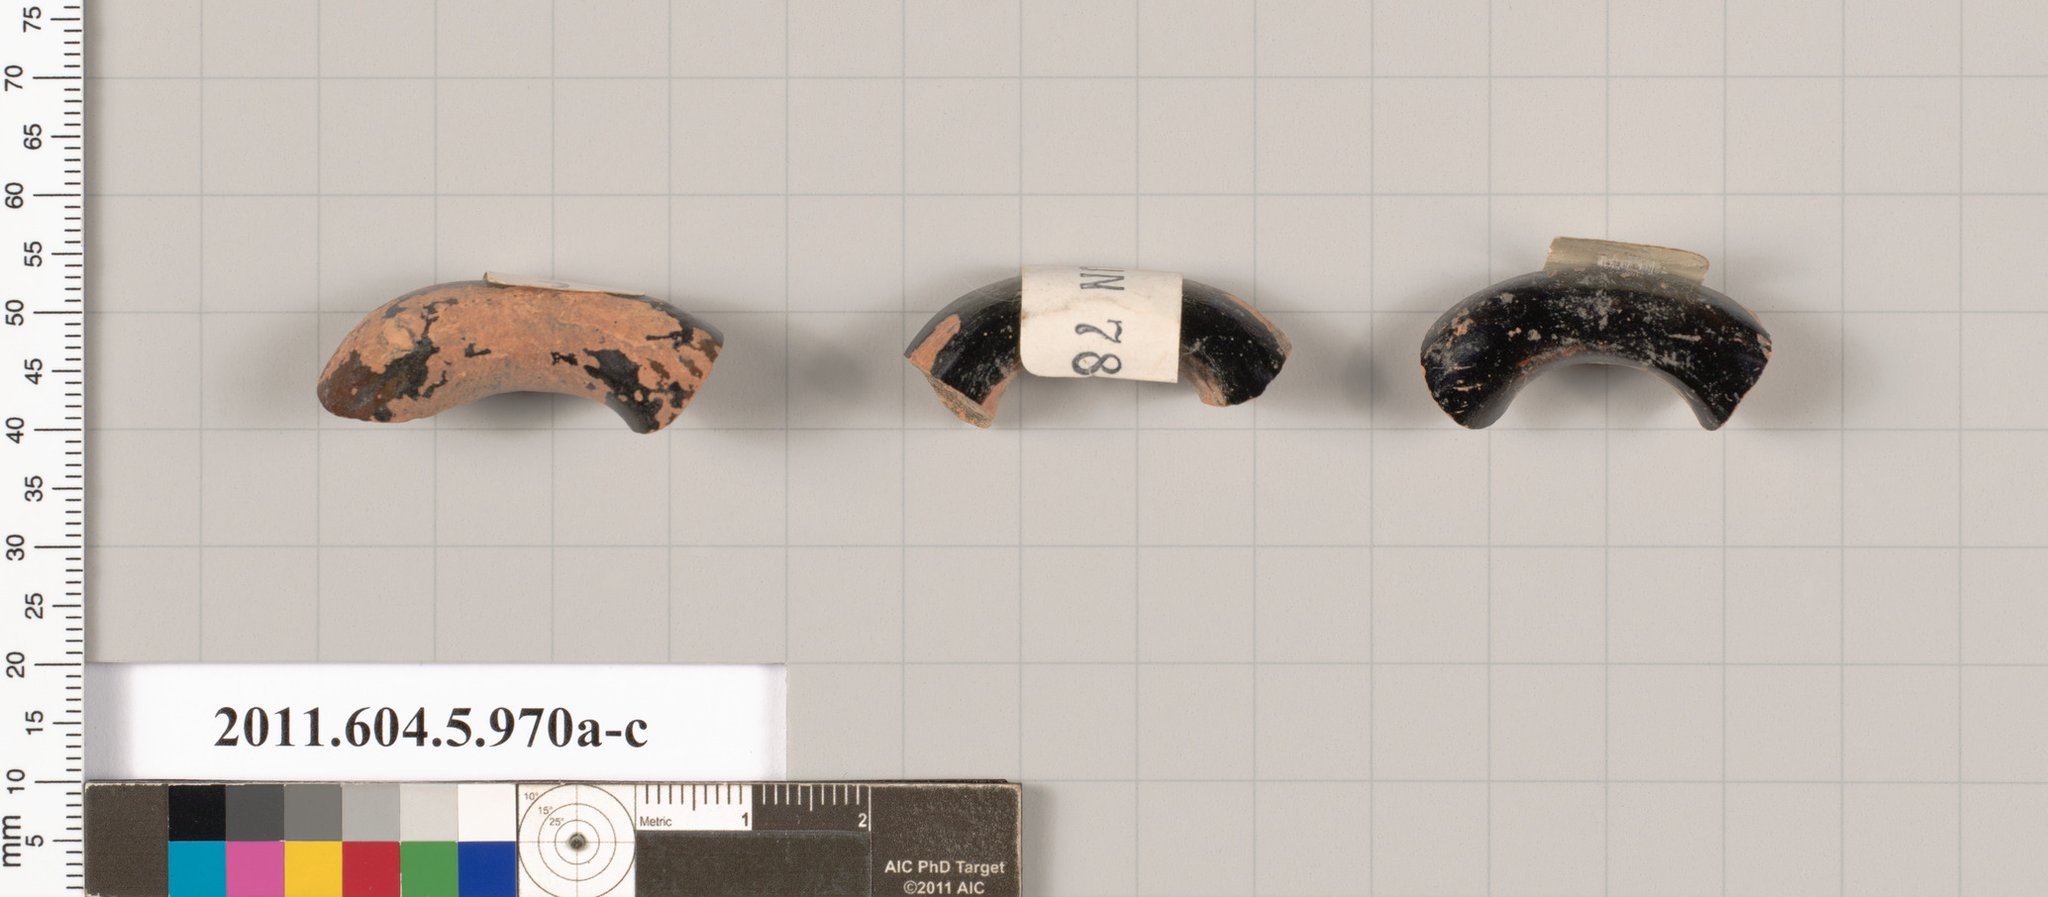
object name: kylix fragment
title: Terracotta fragments of kylikes (drinking cups)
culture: greek, attic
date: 600-401 BCE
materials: terracotta